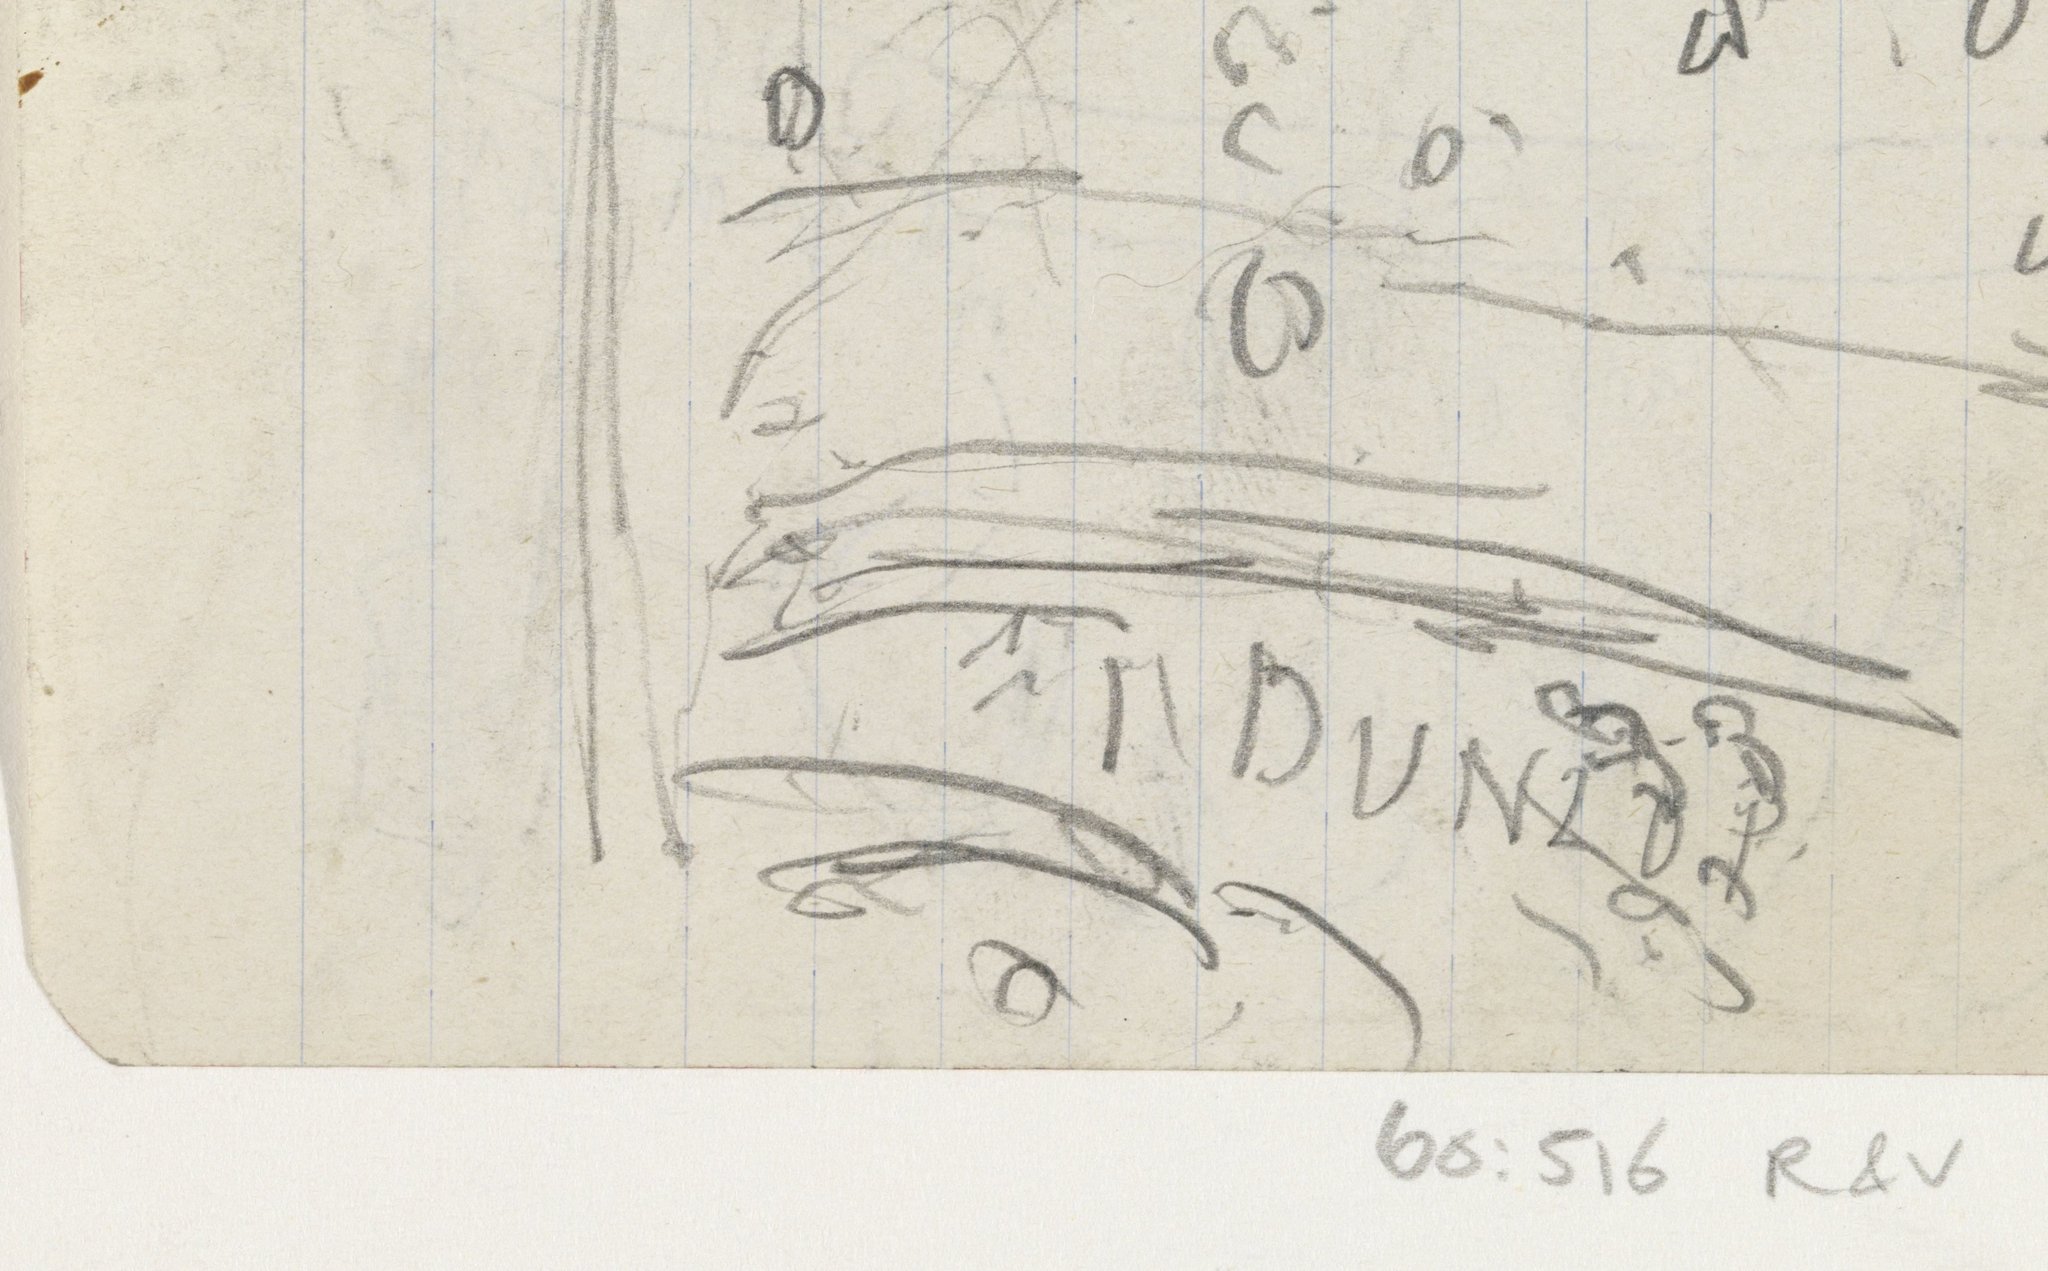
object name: drawing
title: Wielerwedstrijd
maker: leo gestel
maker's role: draughtsman, print maker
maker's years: 1881-1941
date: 1891-1941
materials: pencil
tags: crowd, mob, bicycle racing